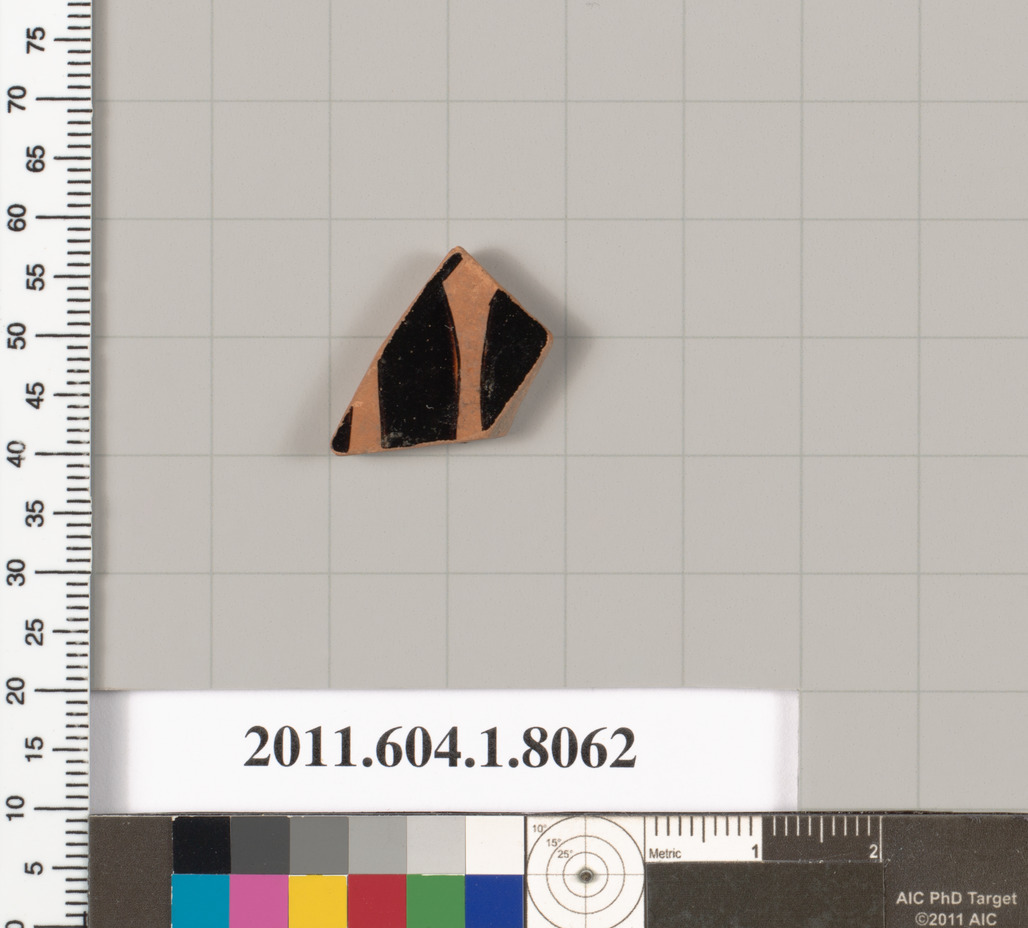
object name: kylix fragment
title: Terracotta fragment of a kylix (drinking cup)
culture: greek, attic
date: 510-490 BCE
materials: terracotta